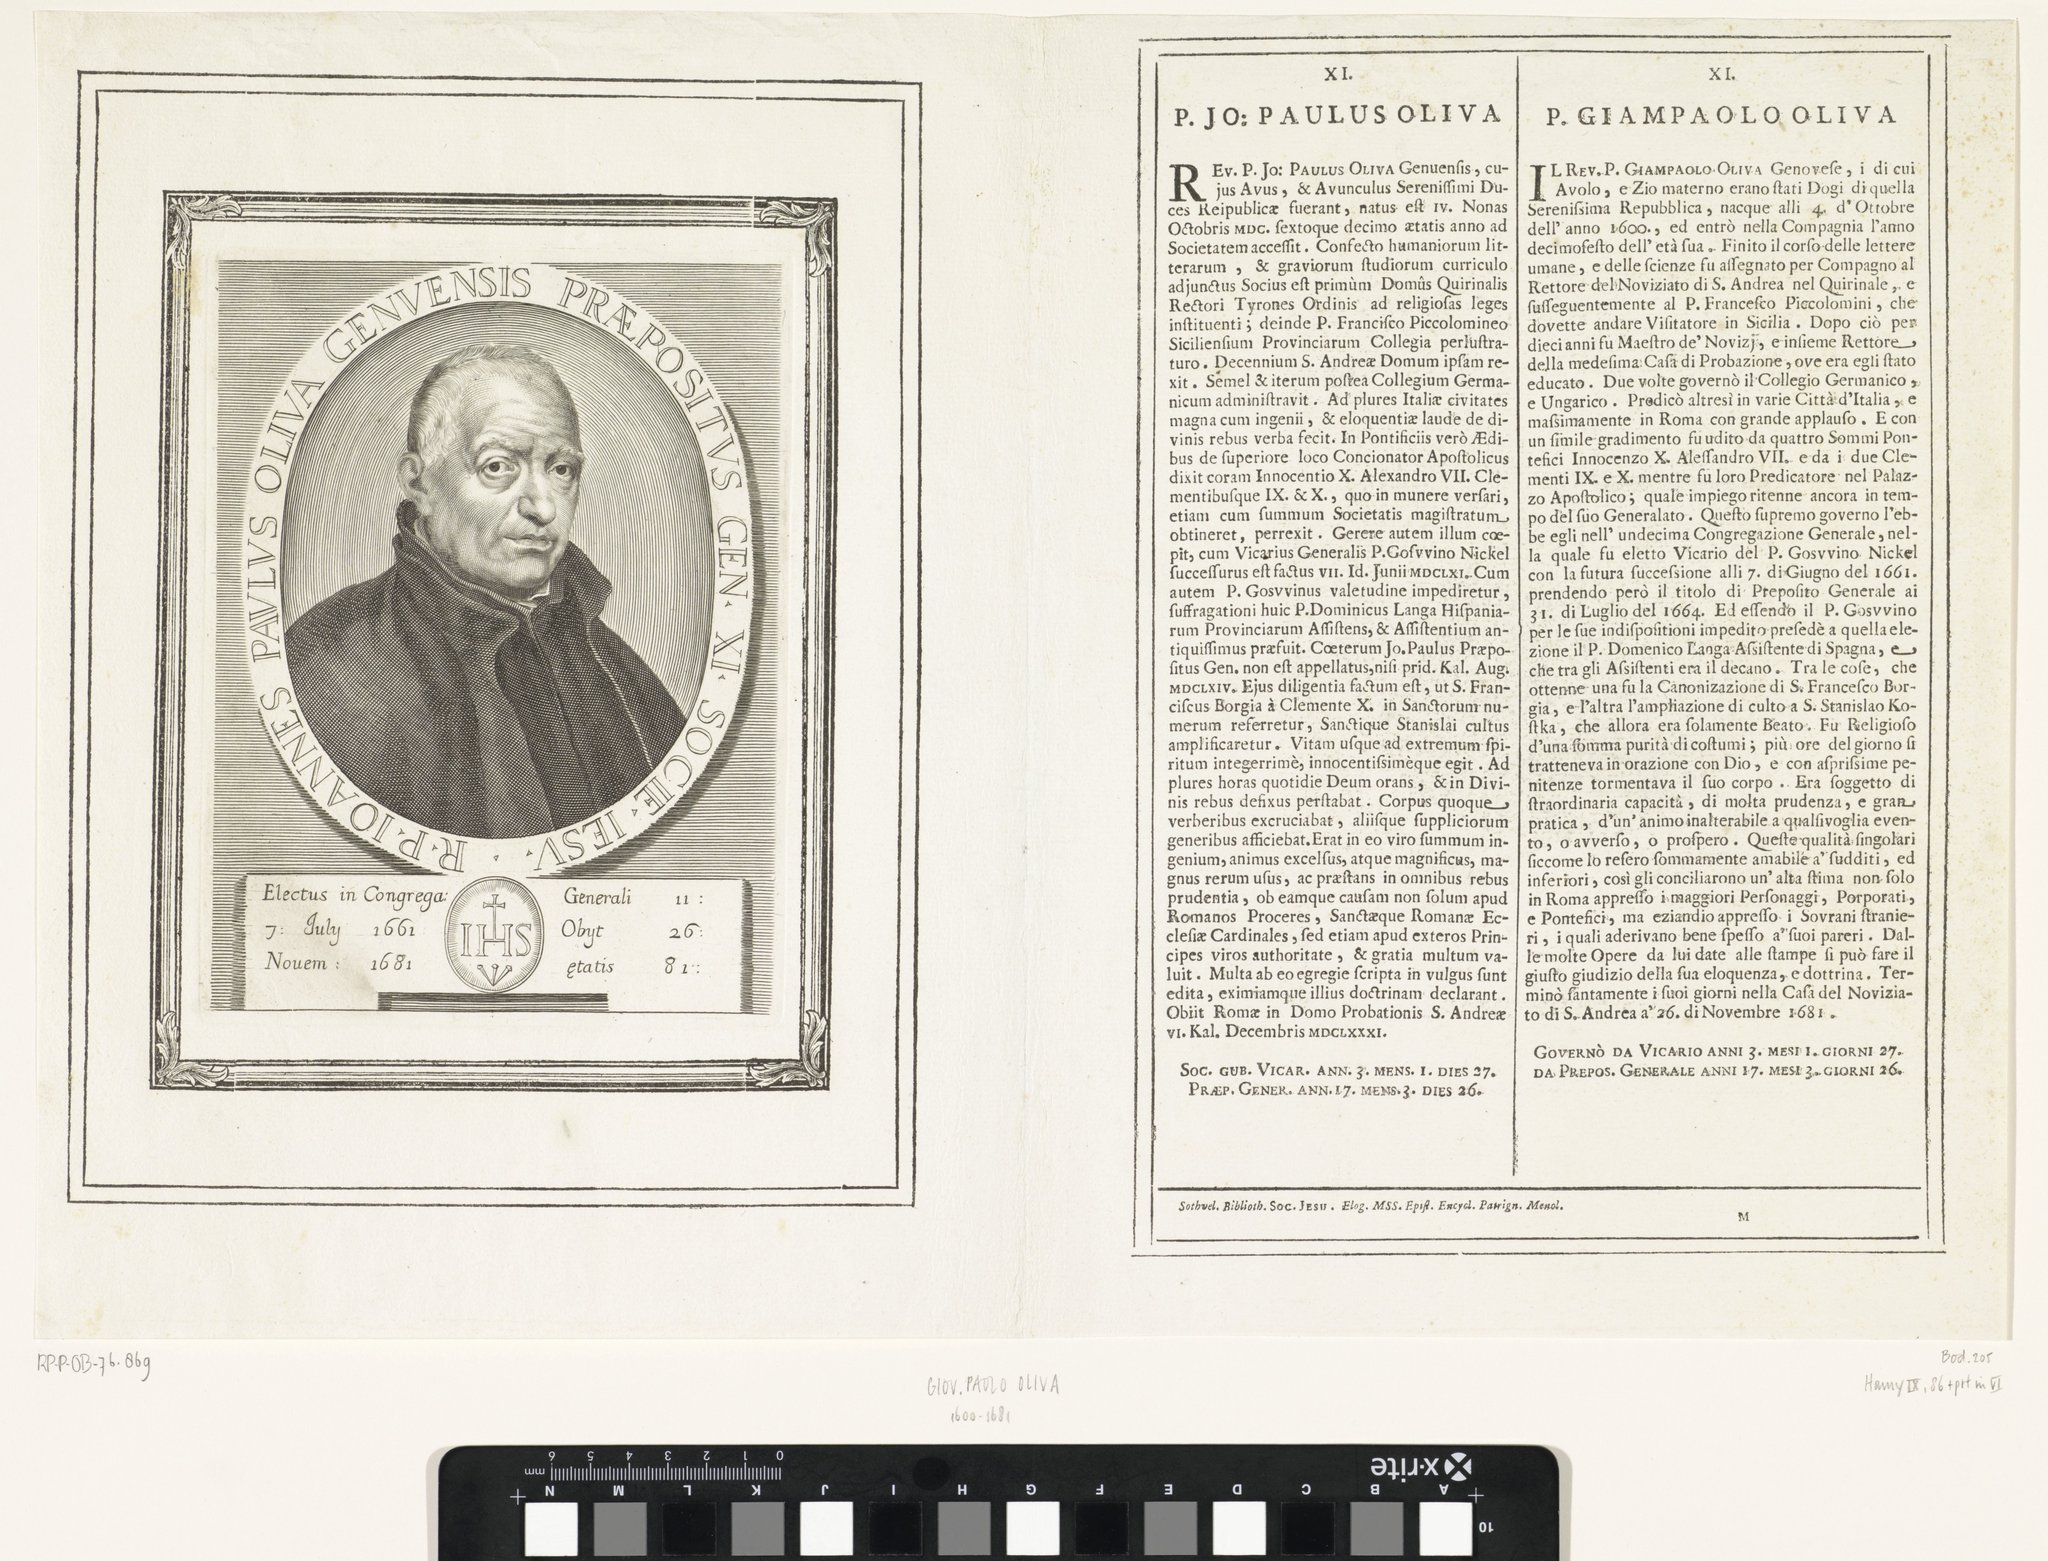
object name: print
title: Portret van de Italiaanse priester Giovanni Paolo Oliva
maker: arnold van westerhout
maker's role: print maker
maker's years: 1651-1725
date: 1751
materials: paper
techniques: engraving, etching, letterpress printing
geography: italy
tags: priest, ihs ('iesus hominum salvator') ~ symbol of christ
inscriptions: inscription: ‘Electus In Congrega: Generali II: / 7 July 1661 Obijt 26: / Novemb. 1681 aetatis 81’, collector's mark: Lugt 2228, title: ‘R.P. JOANNES PAULUS OLIVA GENUENSIS PRAEPOSITUS GEN. XI. SOCIE. IESU’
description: Prent gebruikt in: Galeotti, Niccolò. Imagines praepositorum generalium Societatis Jesu, delineatae, et aereis formis expressae ab Arnoldo Van Westherhout, addita perbrevi uniuscujusque vitae descriptione. Rome: Monaldini, 1751.